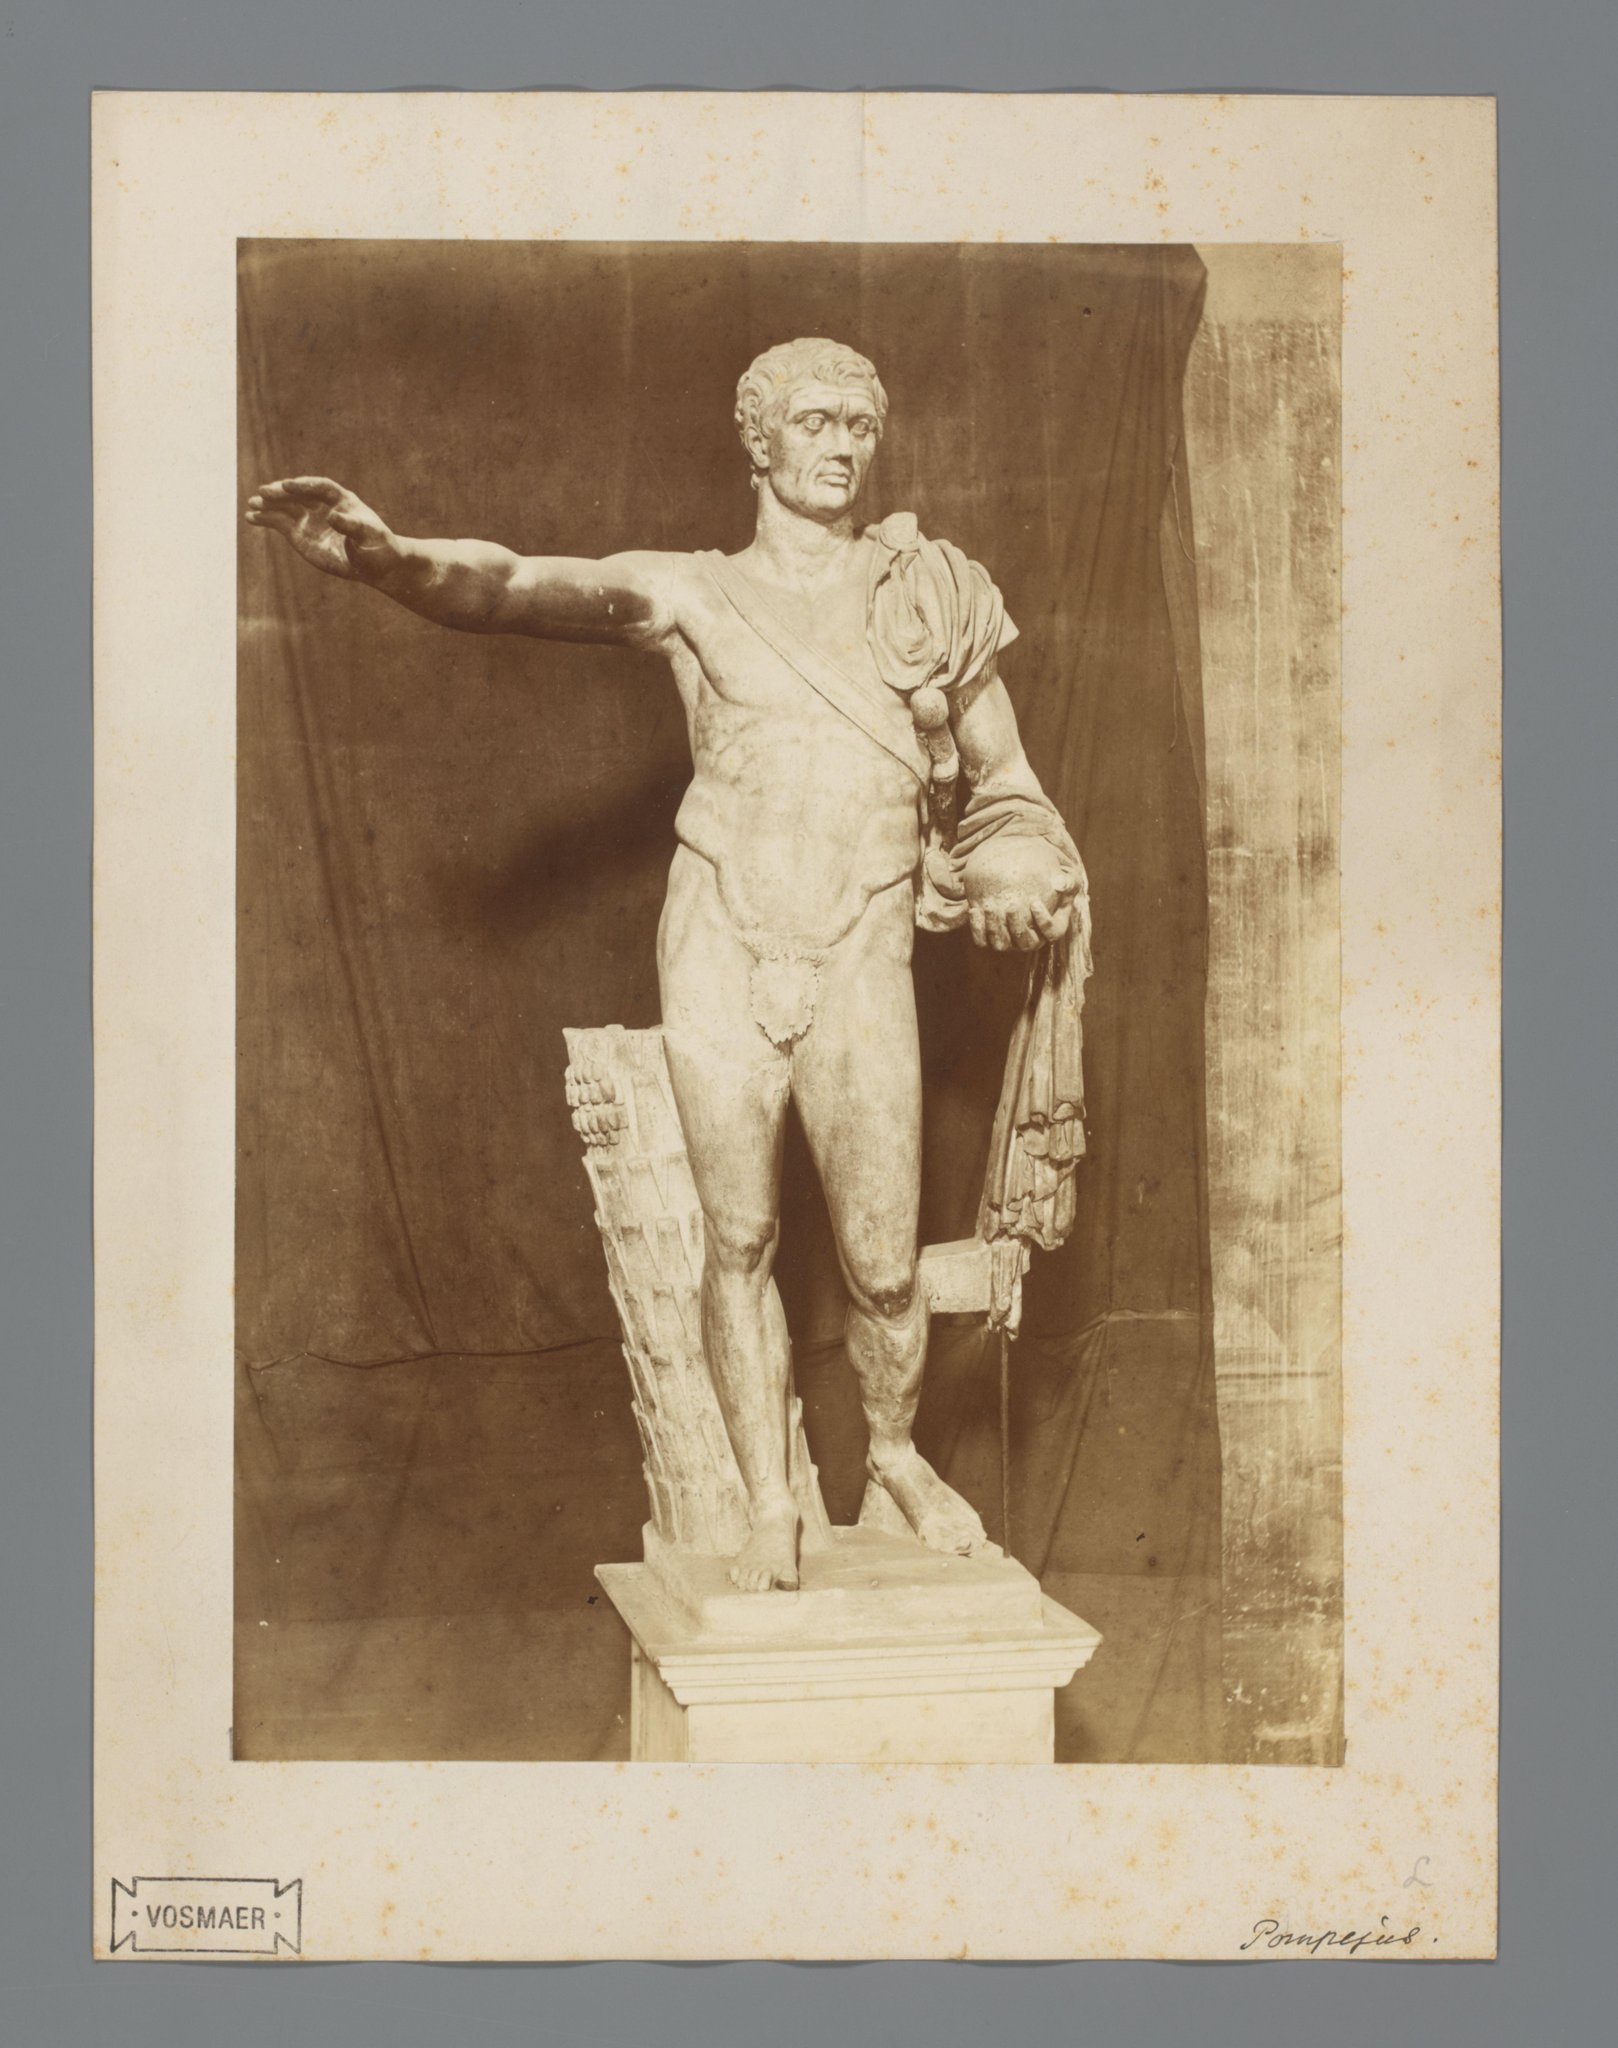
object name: photograph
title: Pompejus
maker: Anonymous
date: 1851-1900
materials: cardboard, paper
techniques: albumen print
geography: rome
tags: rome, politician, monument, statue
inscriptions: collector's mark: ‘VOSMAER’